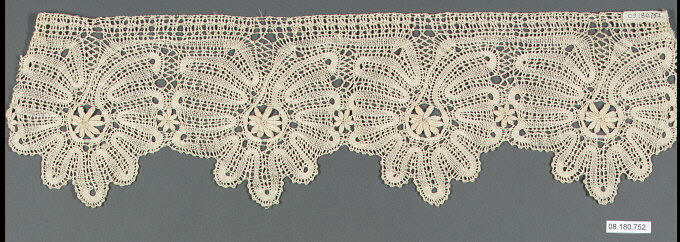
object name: fragment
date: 1801-1900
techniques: lace